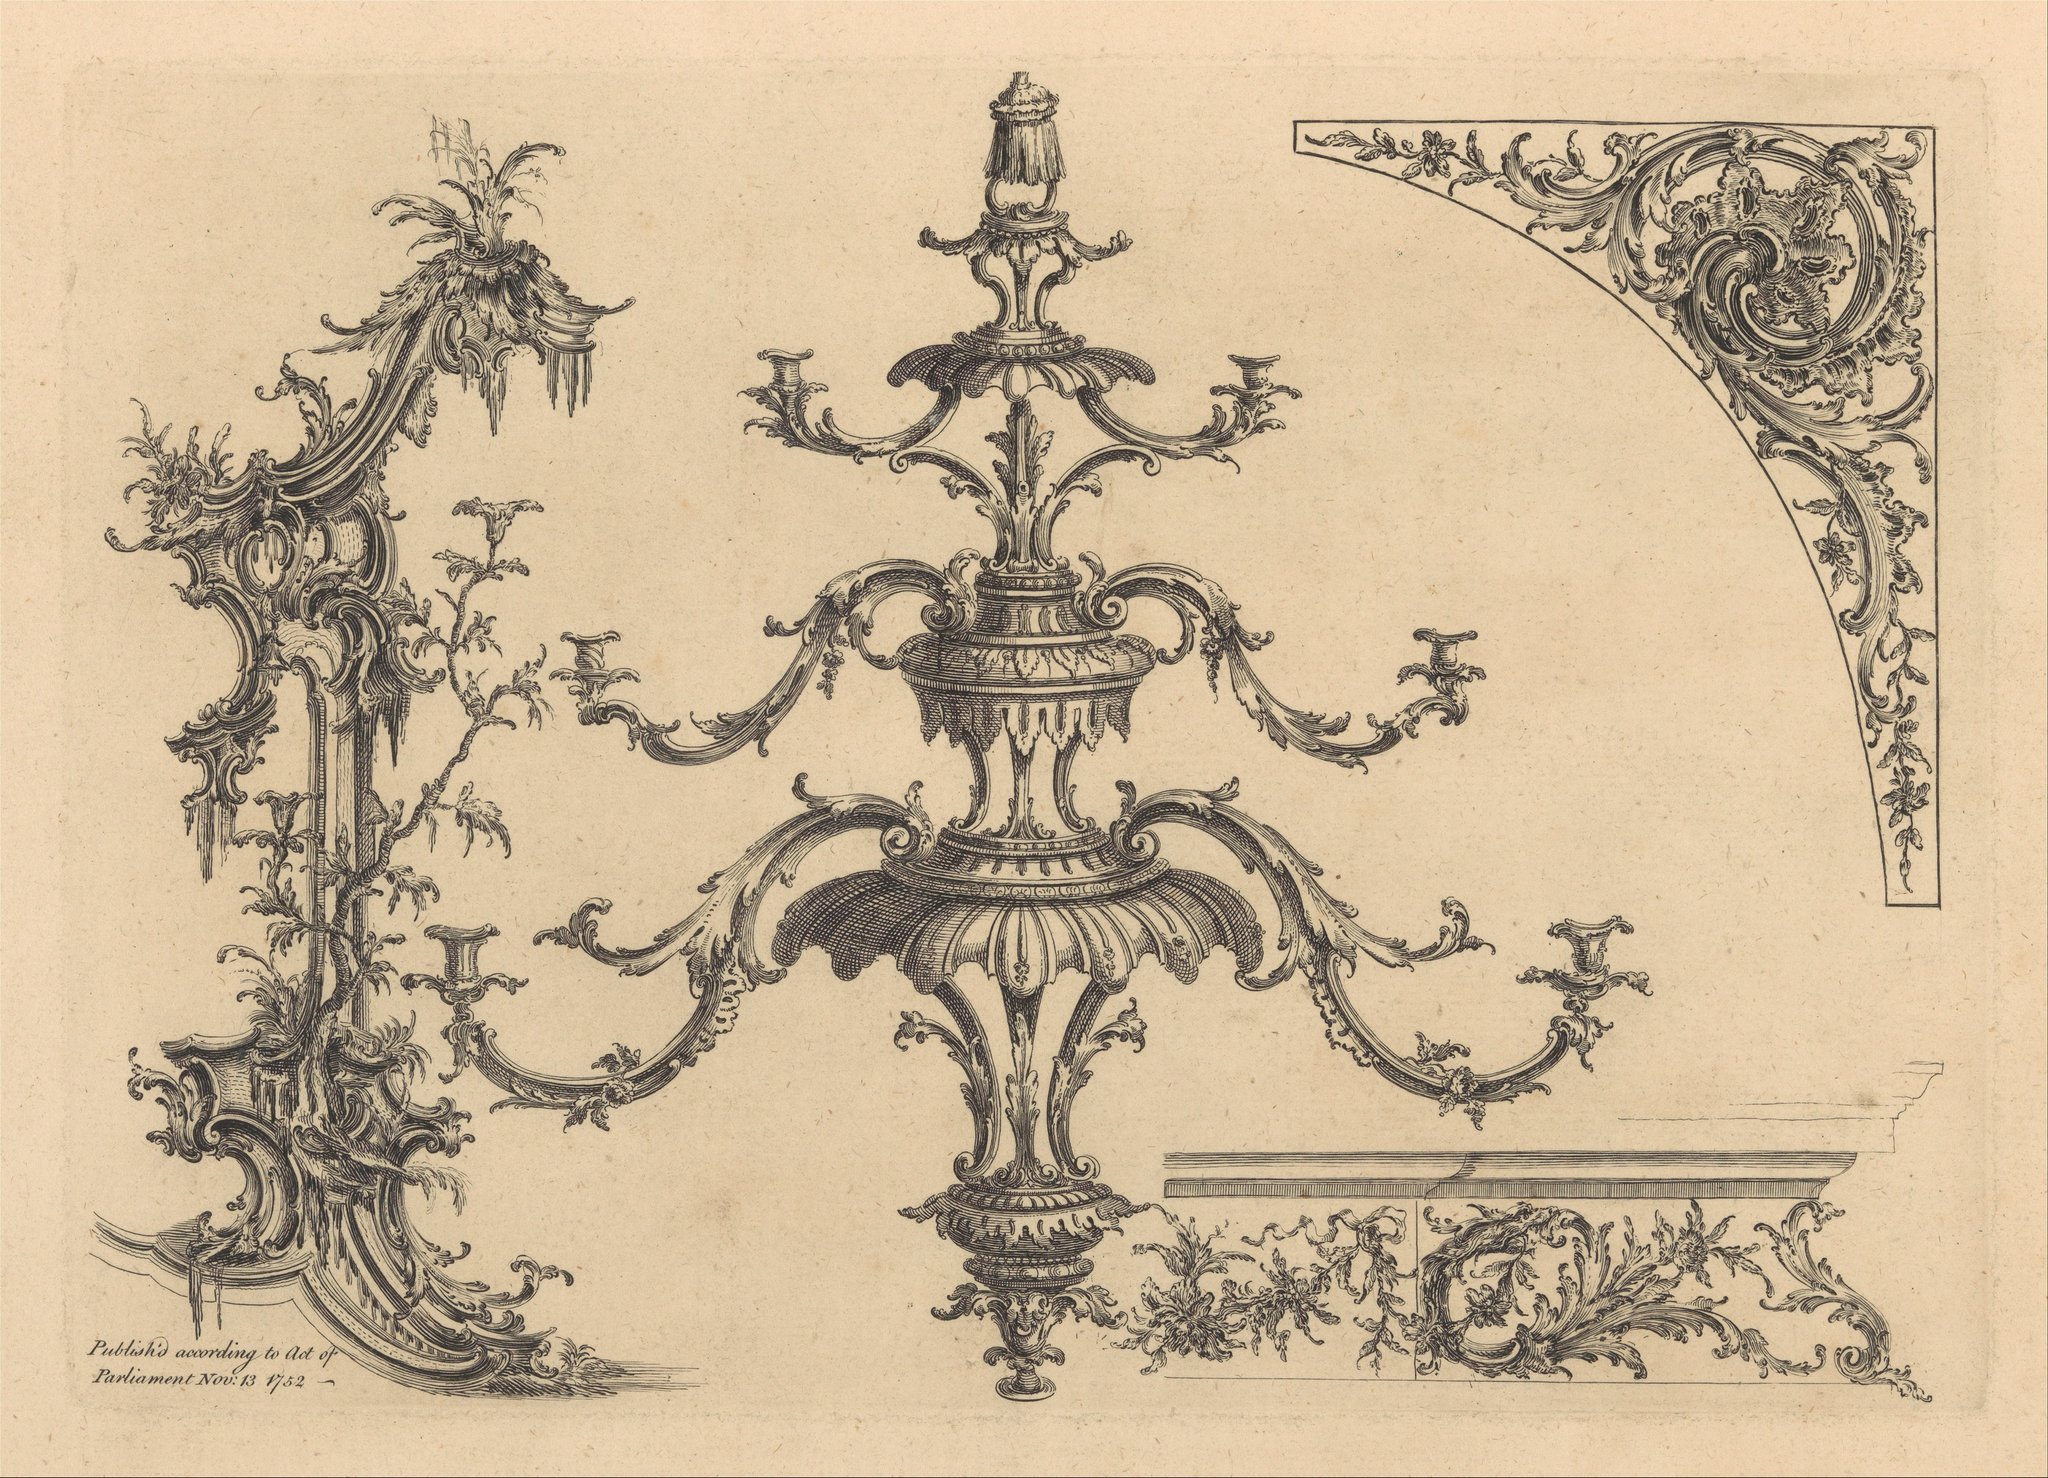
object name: book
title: 12 plates from 'A New Book of Ornaments with Twelve Leaves Consisting of Chimneys, Sconces, Tables, Spandle Panels, Spring Clock Cases, Stands, a Chandelier and Girandole, etc.'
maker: matthias lock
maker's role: designer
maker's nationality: british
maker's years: 1705-1760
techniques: etching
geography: england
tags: ornament